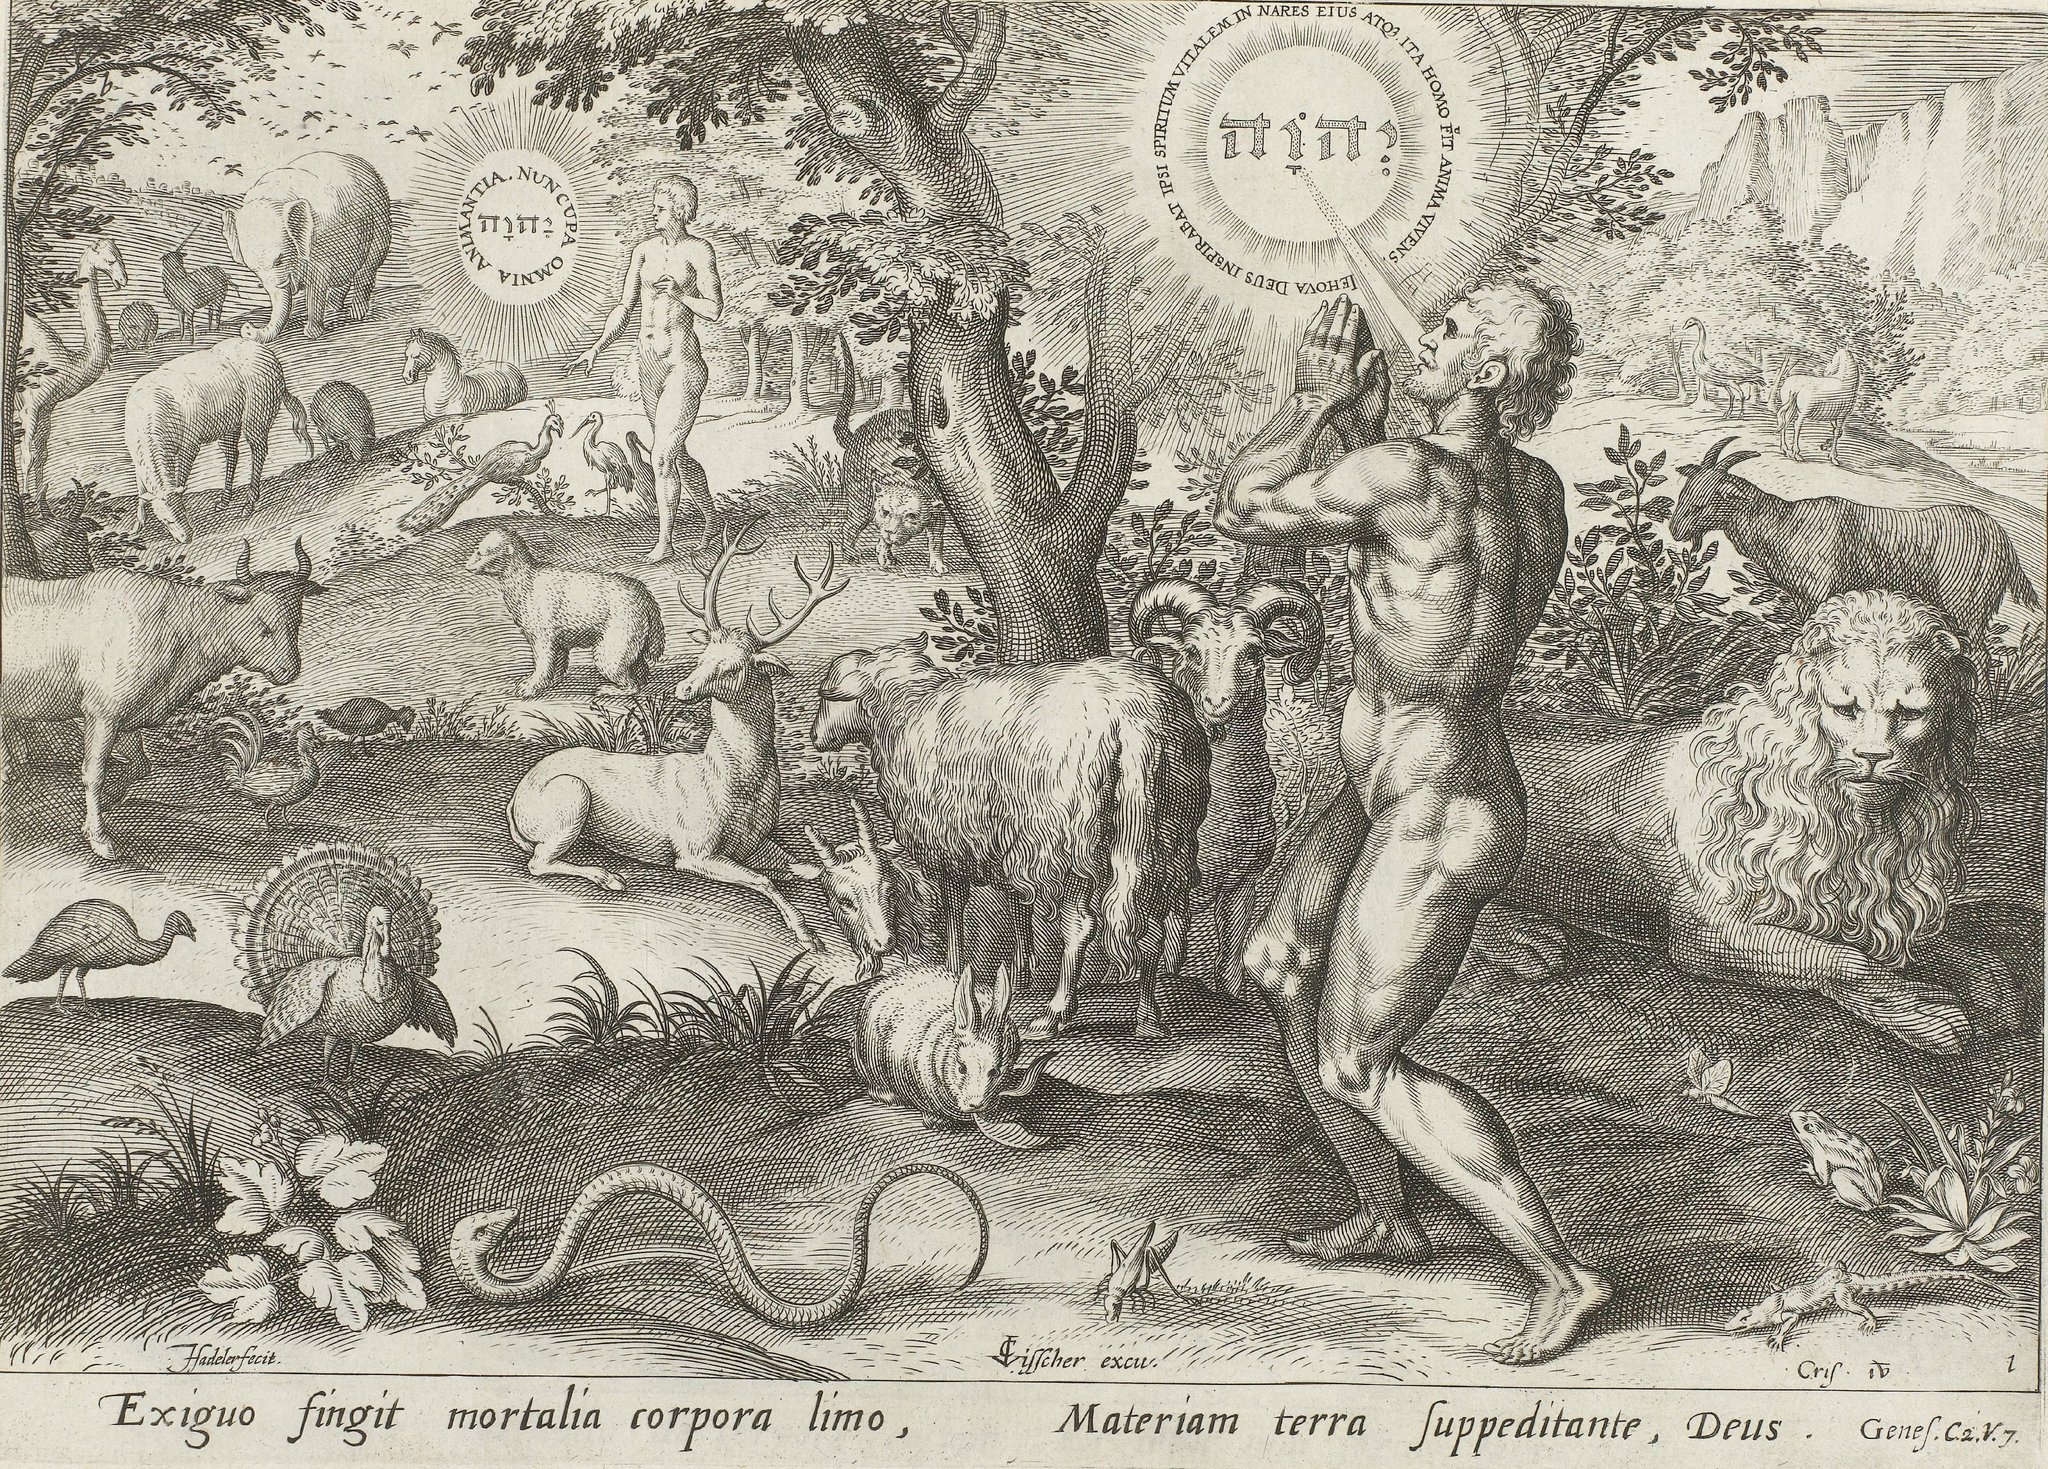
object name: album leaf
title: Theatrum Biblicum Hoc Est Historiae Sacrae Veteris et Novi Testamenti Tabulis Aeneis Expressae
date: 1643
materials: paper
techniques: engraving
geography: amsterdam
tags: adam naming the animals, animals, the man (adam) comes to life: usually god reaches out his hand or breathes life into his nostrils, tetragram (in roman or hebrew script) ~ symbol of god the father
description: De schepping van Adam. Op de voorgrond staat God de Vader in de gedaante van het tetragram die de naakte Adam leven inblaast. Op de achtergrond geeft God Adam de opdracht om de dieren namen te geven. Onderaan een verwijzing naar de Bijbeltekst in het Latijn. Deze prent maakt deel uit van een album.